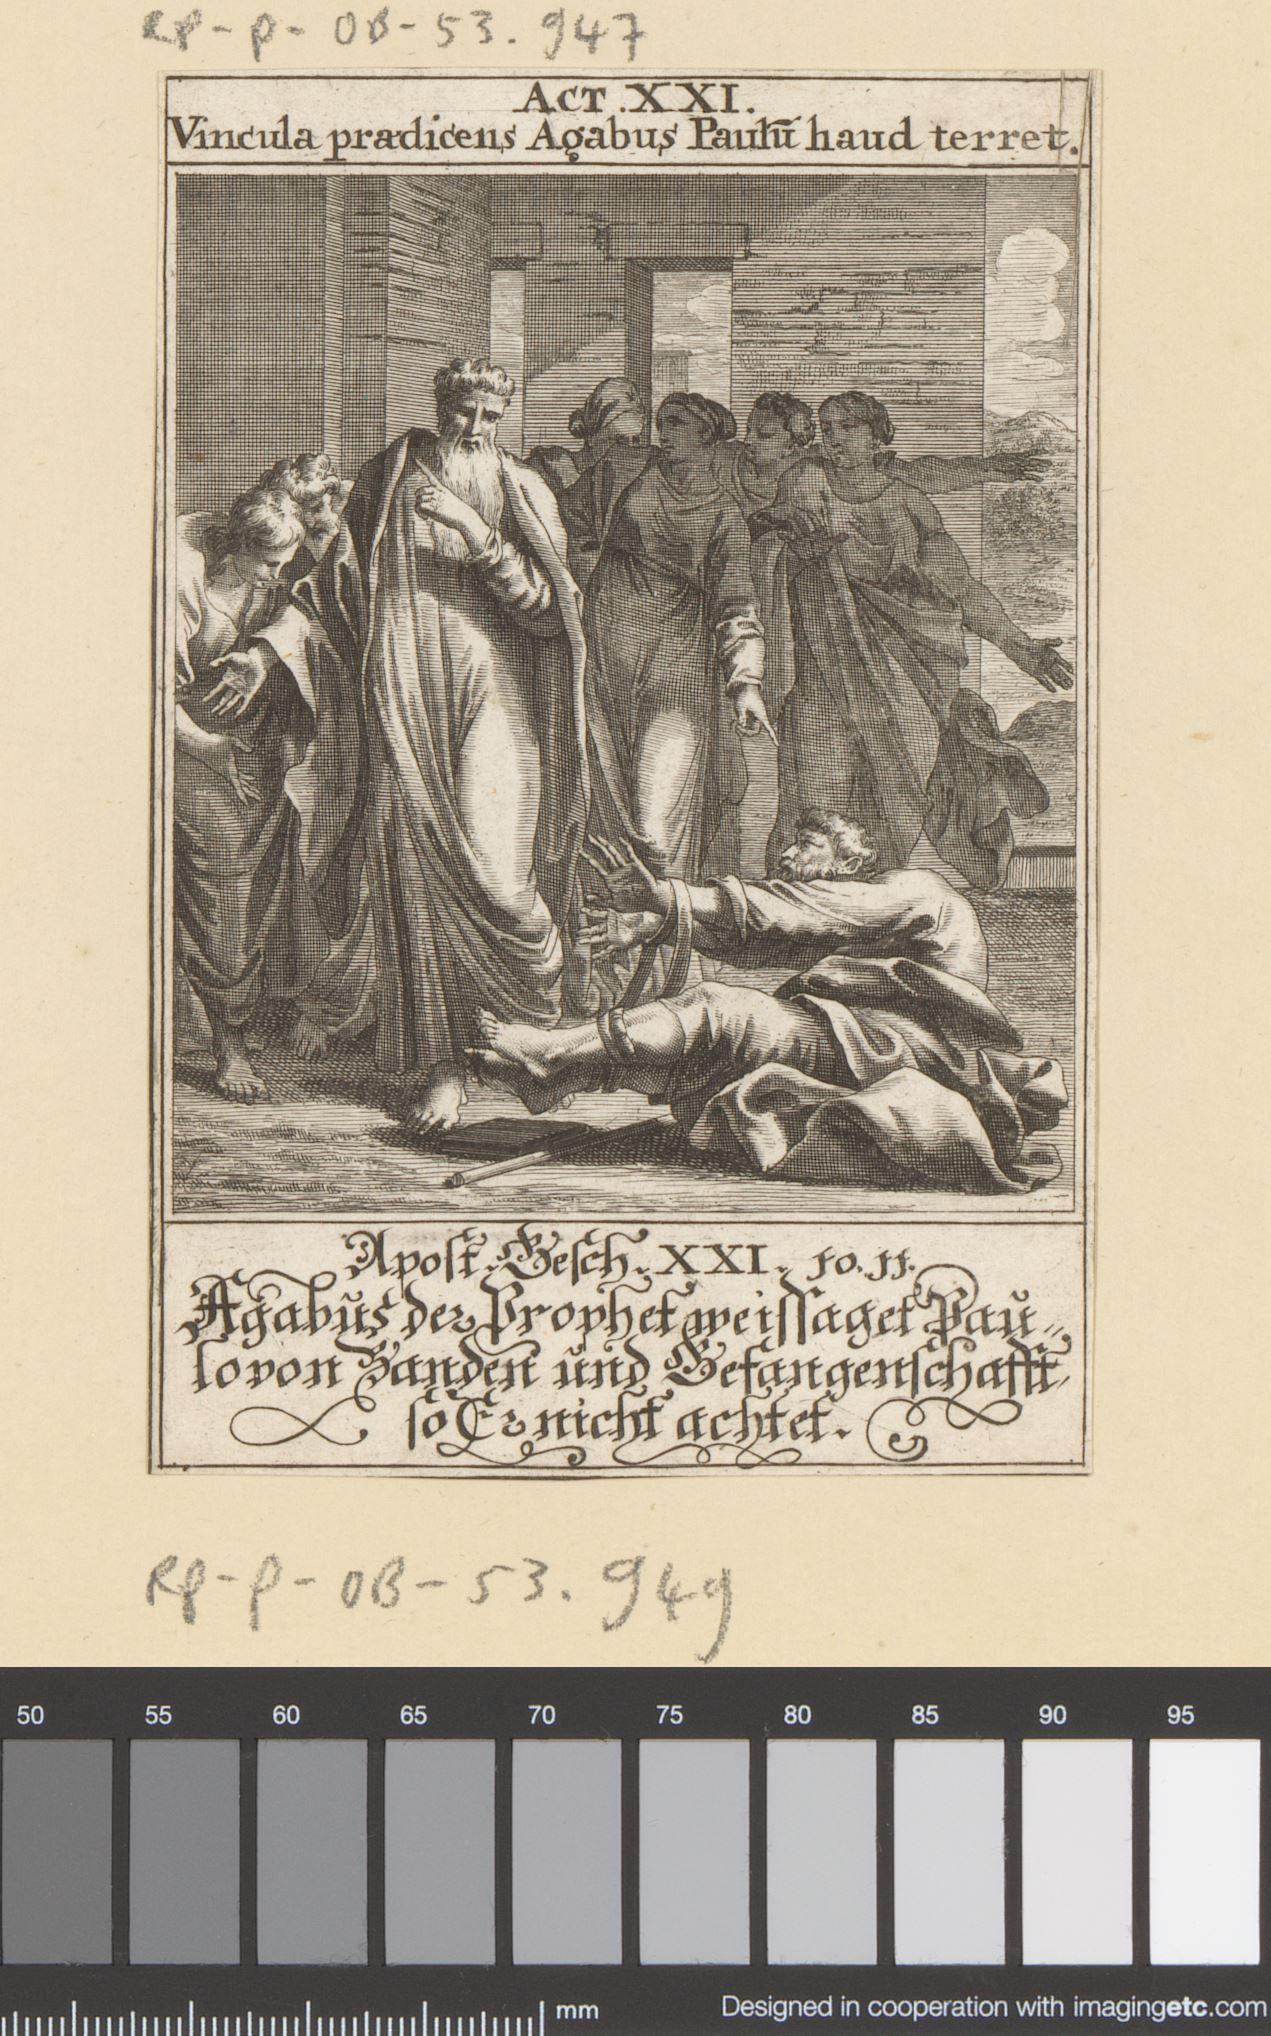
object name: print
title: Profeet Agabus voorspelt de arrestatie van apostel Paulus in Jeruzalem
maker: Anonymous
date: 1697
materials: paper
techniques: etching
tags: the arrest of paul in jerusalem is foretold by agabus, who binds his own hands and feet with paul's girdle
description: Prent ook gebruikt in: Biblia ectypa : Bildnussen auss Heiliger Schrifft. Regensburg: Chr. Wiegel, 1697.